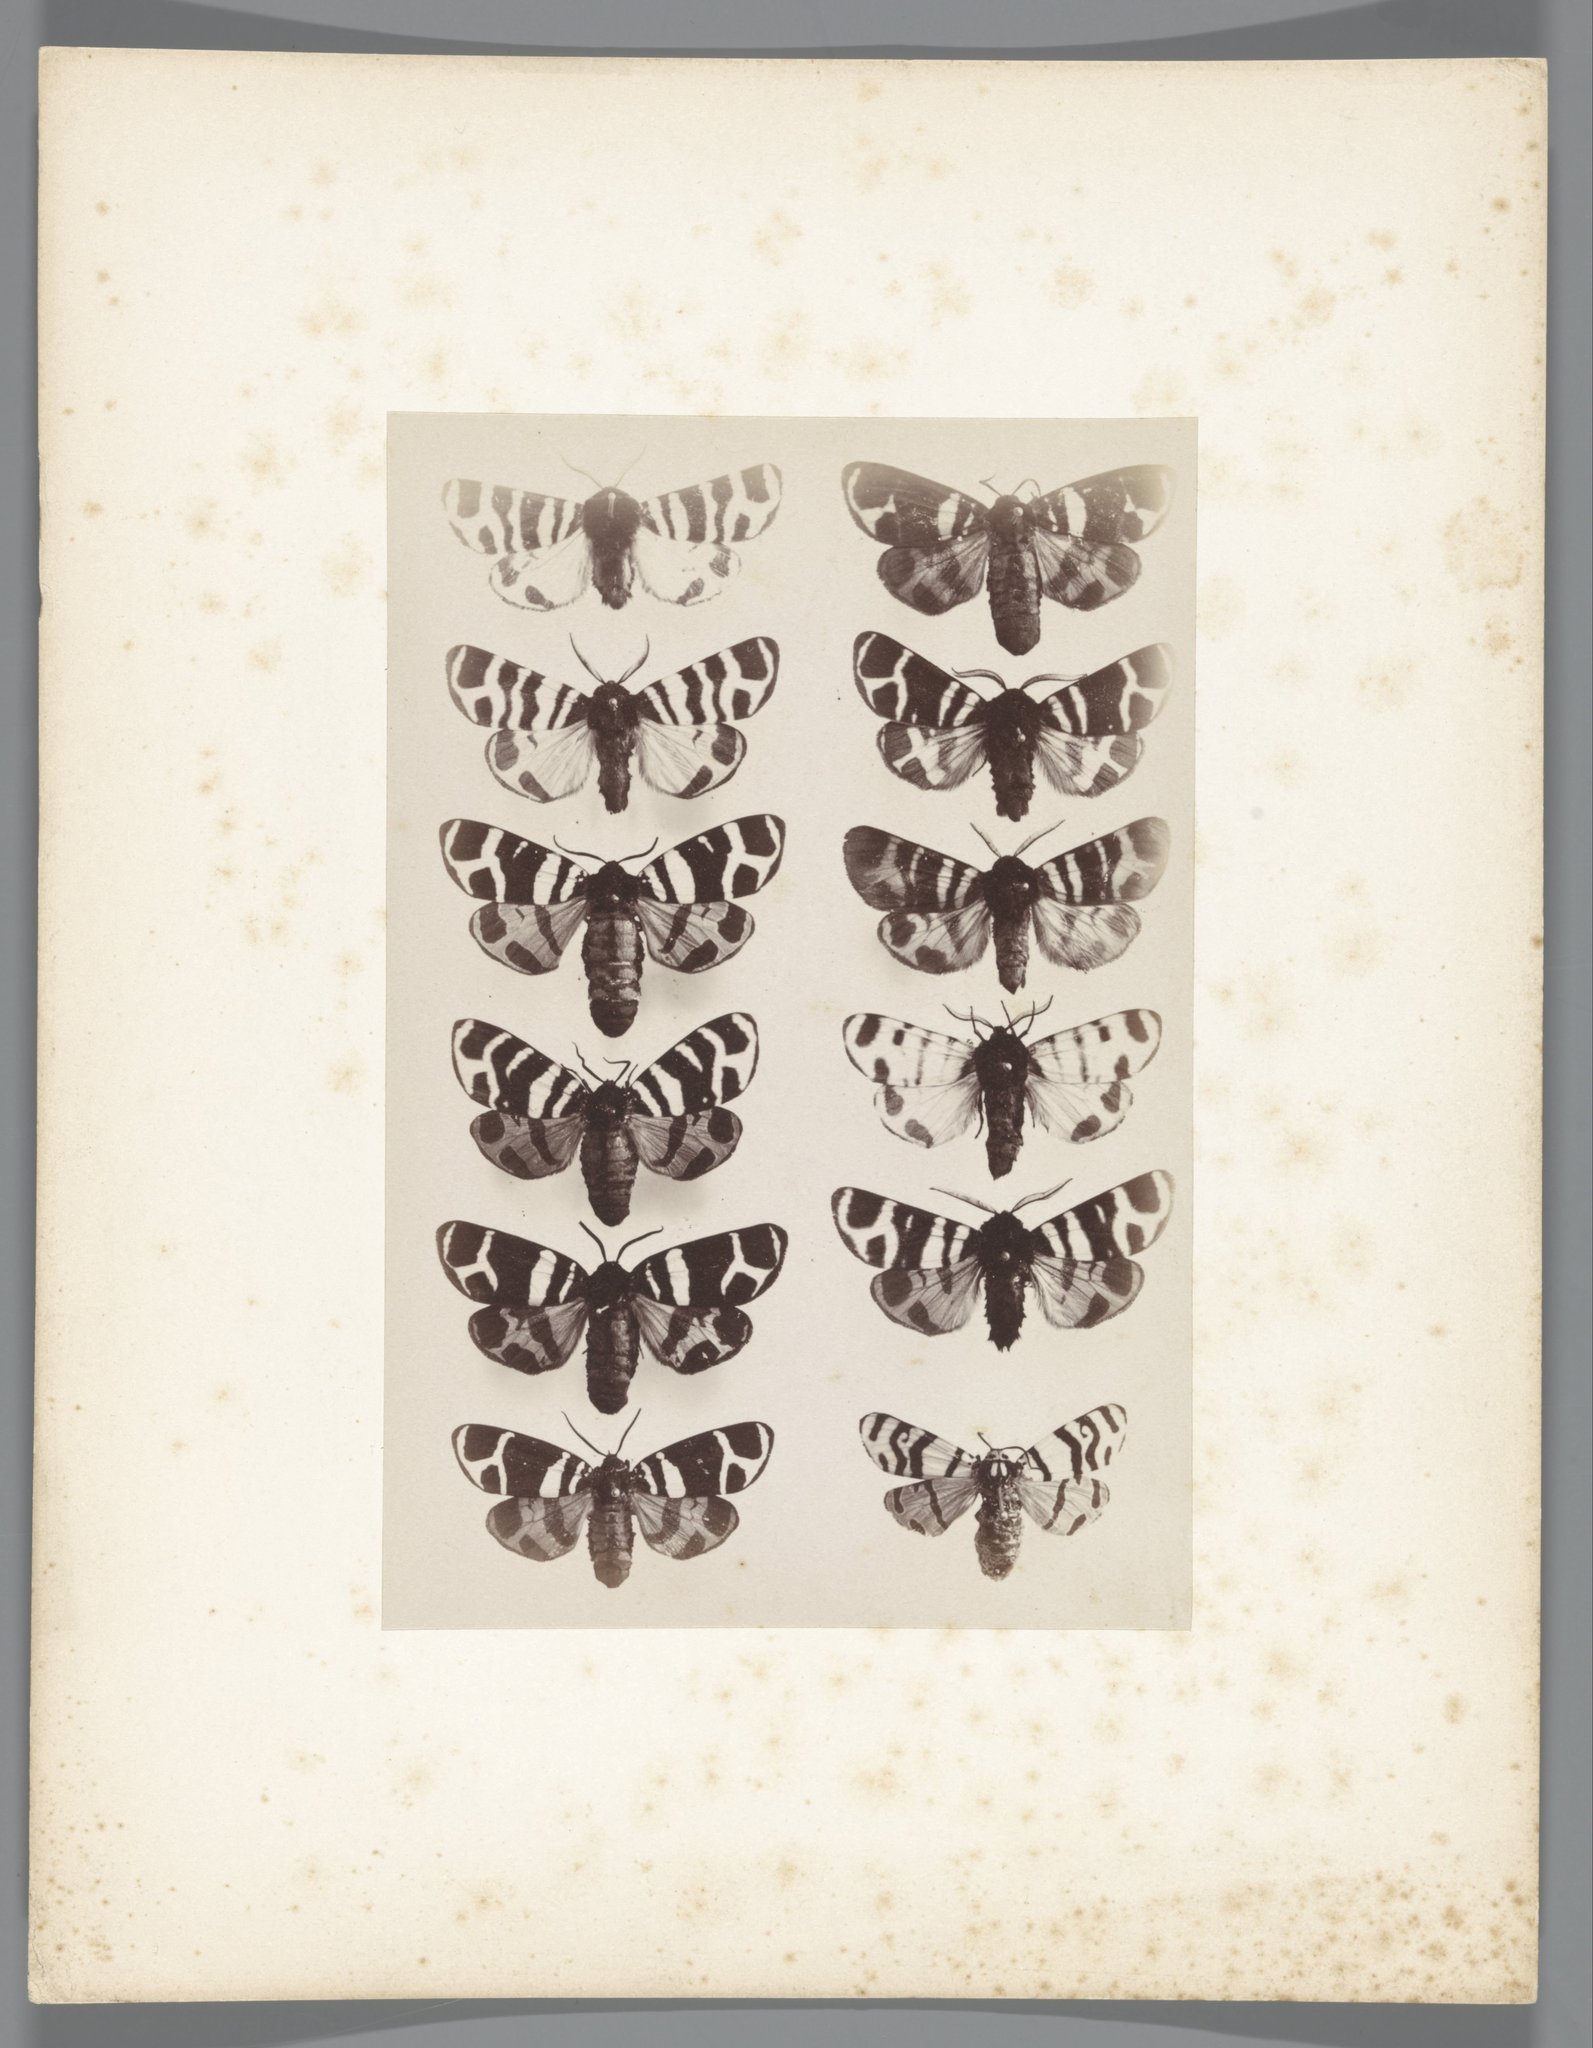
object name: photograph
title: Vlinders uit de collectie van de insectenkenner Charles Oberthür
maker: Anonymous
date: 1889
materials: cardboard, paper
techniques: albumen print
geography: europe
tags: insects: butterfly